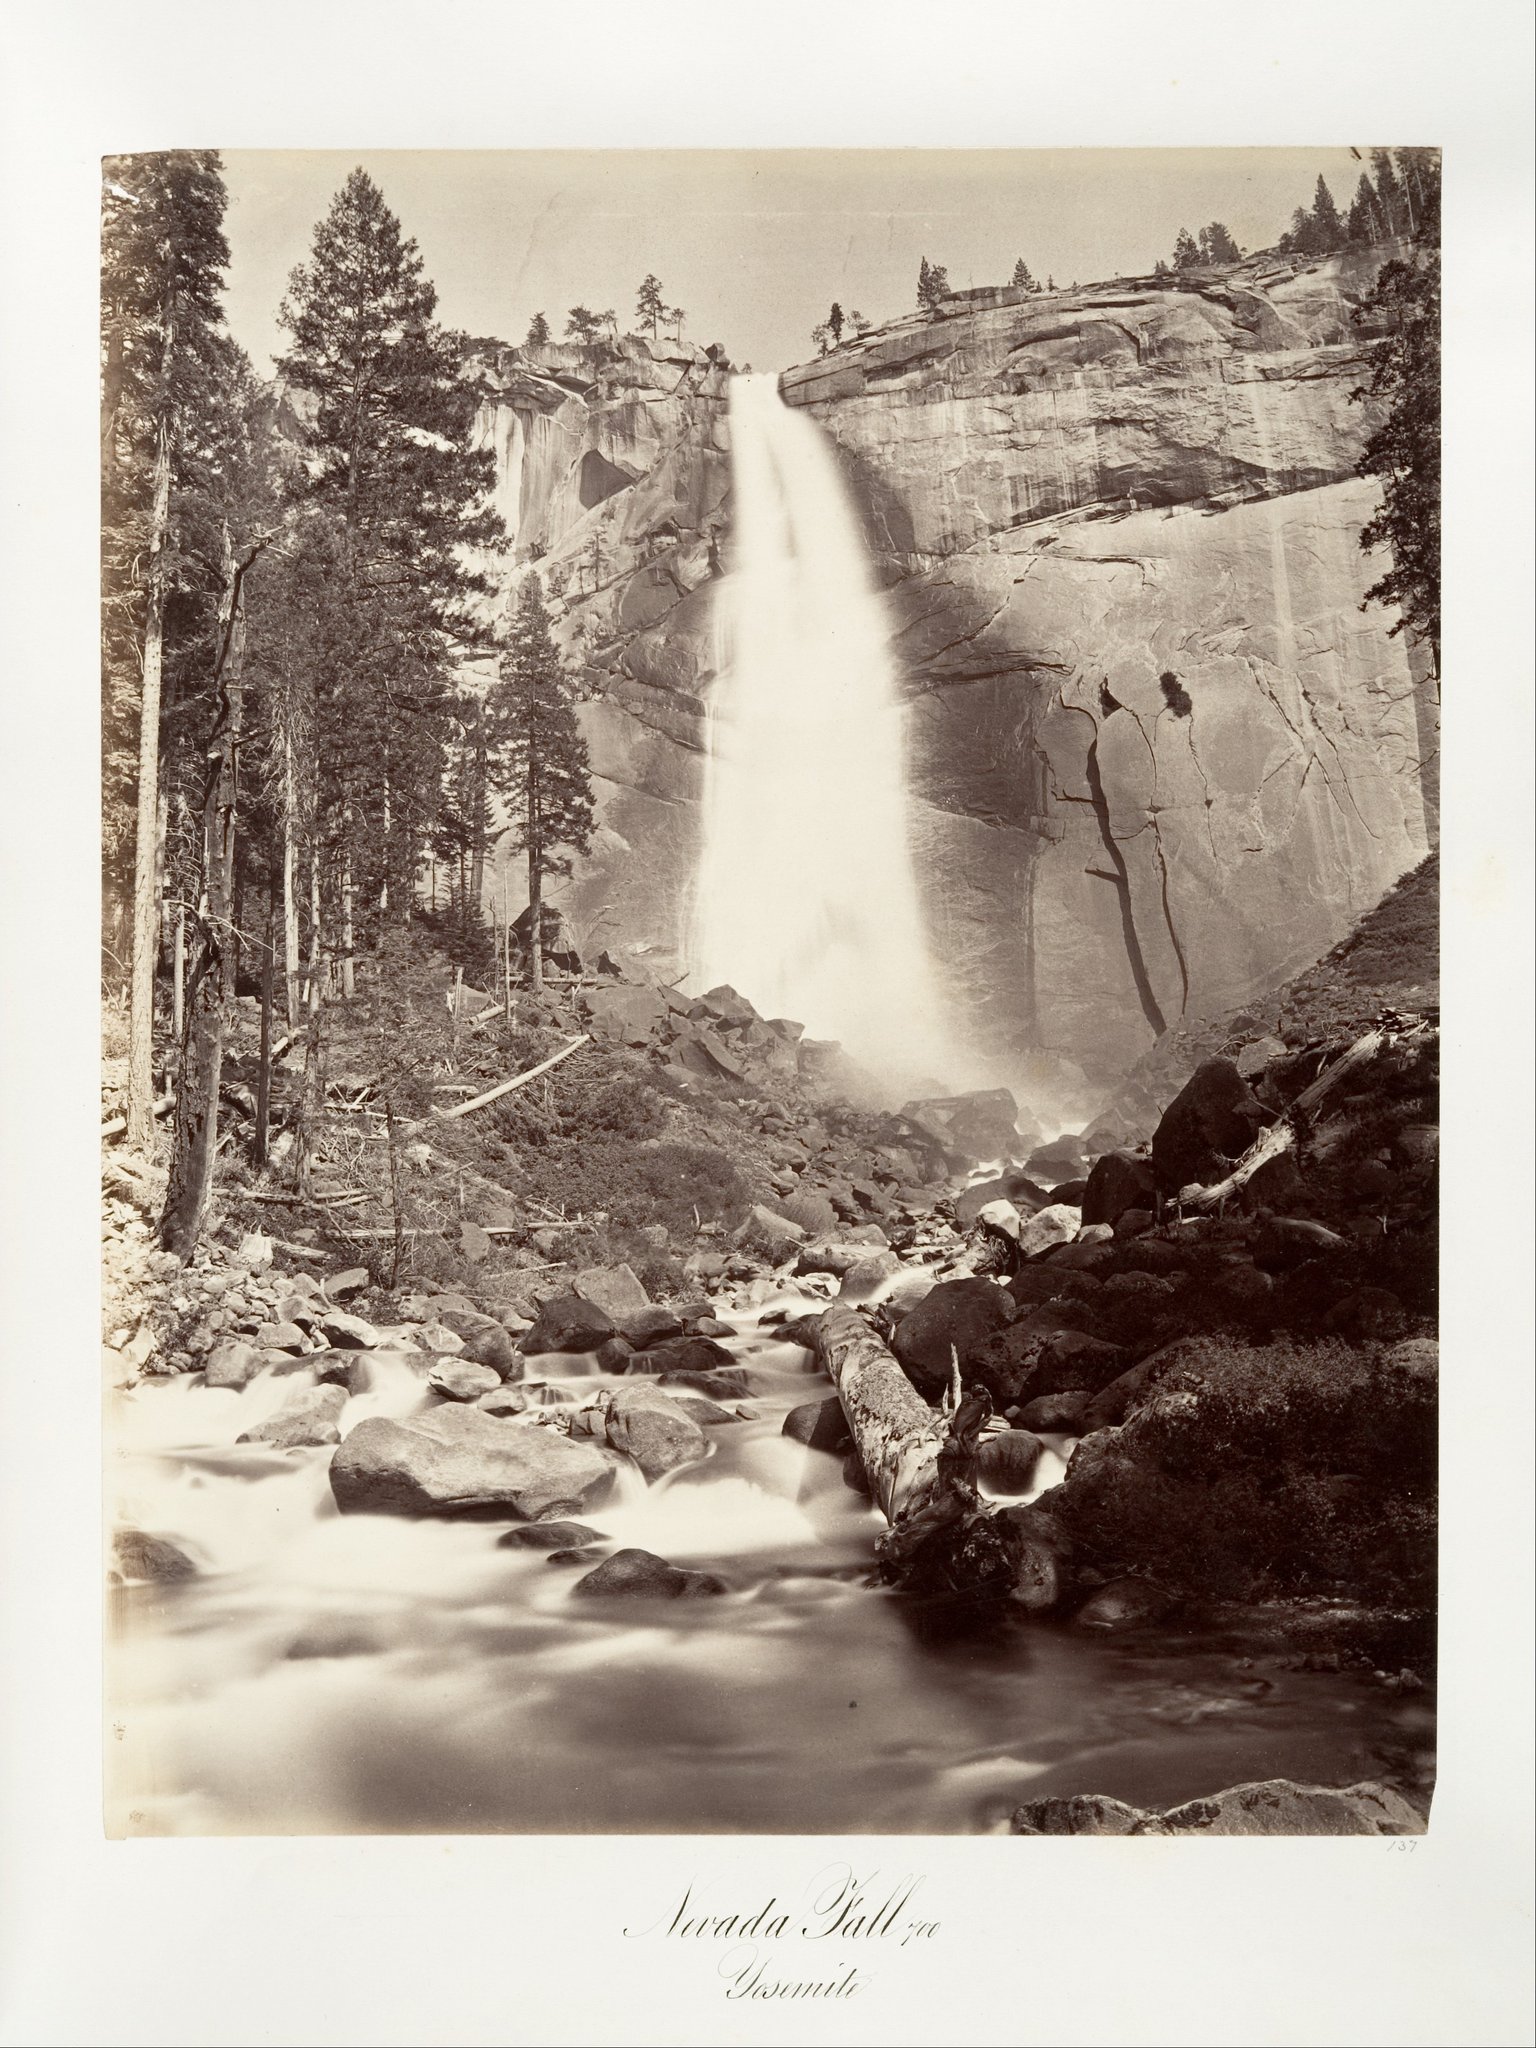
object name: photograph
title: Nevada Fall, 700 feet, Yosemite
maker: carleton e. watkins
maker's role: artist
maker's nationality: american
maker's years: 1829-1916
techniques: albumen silver print, glass negative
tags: waterfalls,mountains,landscapes